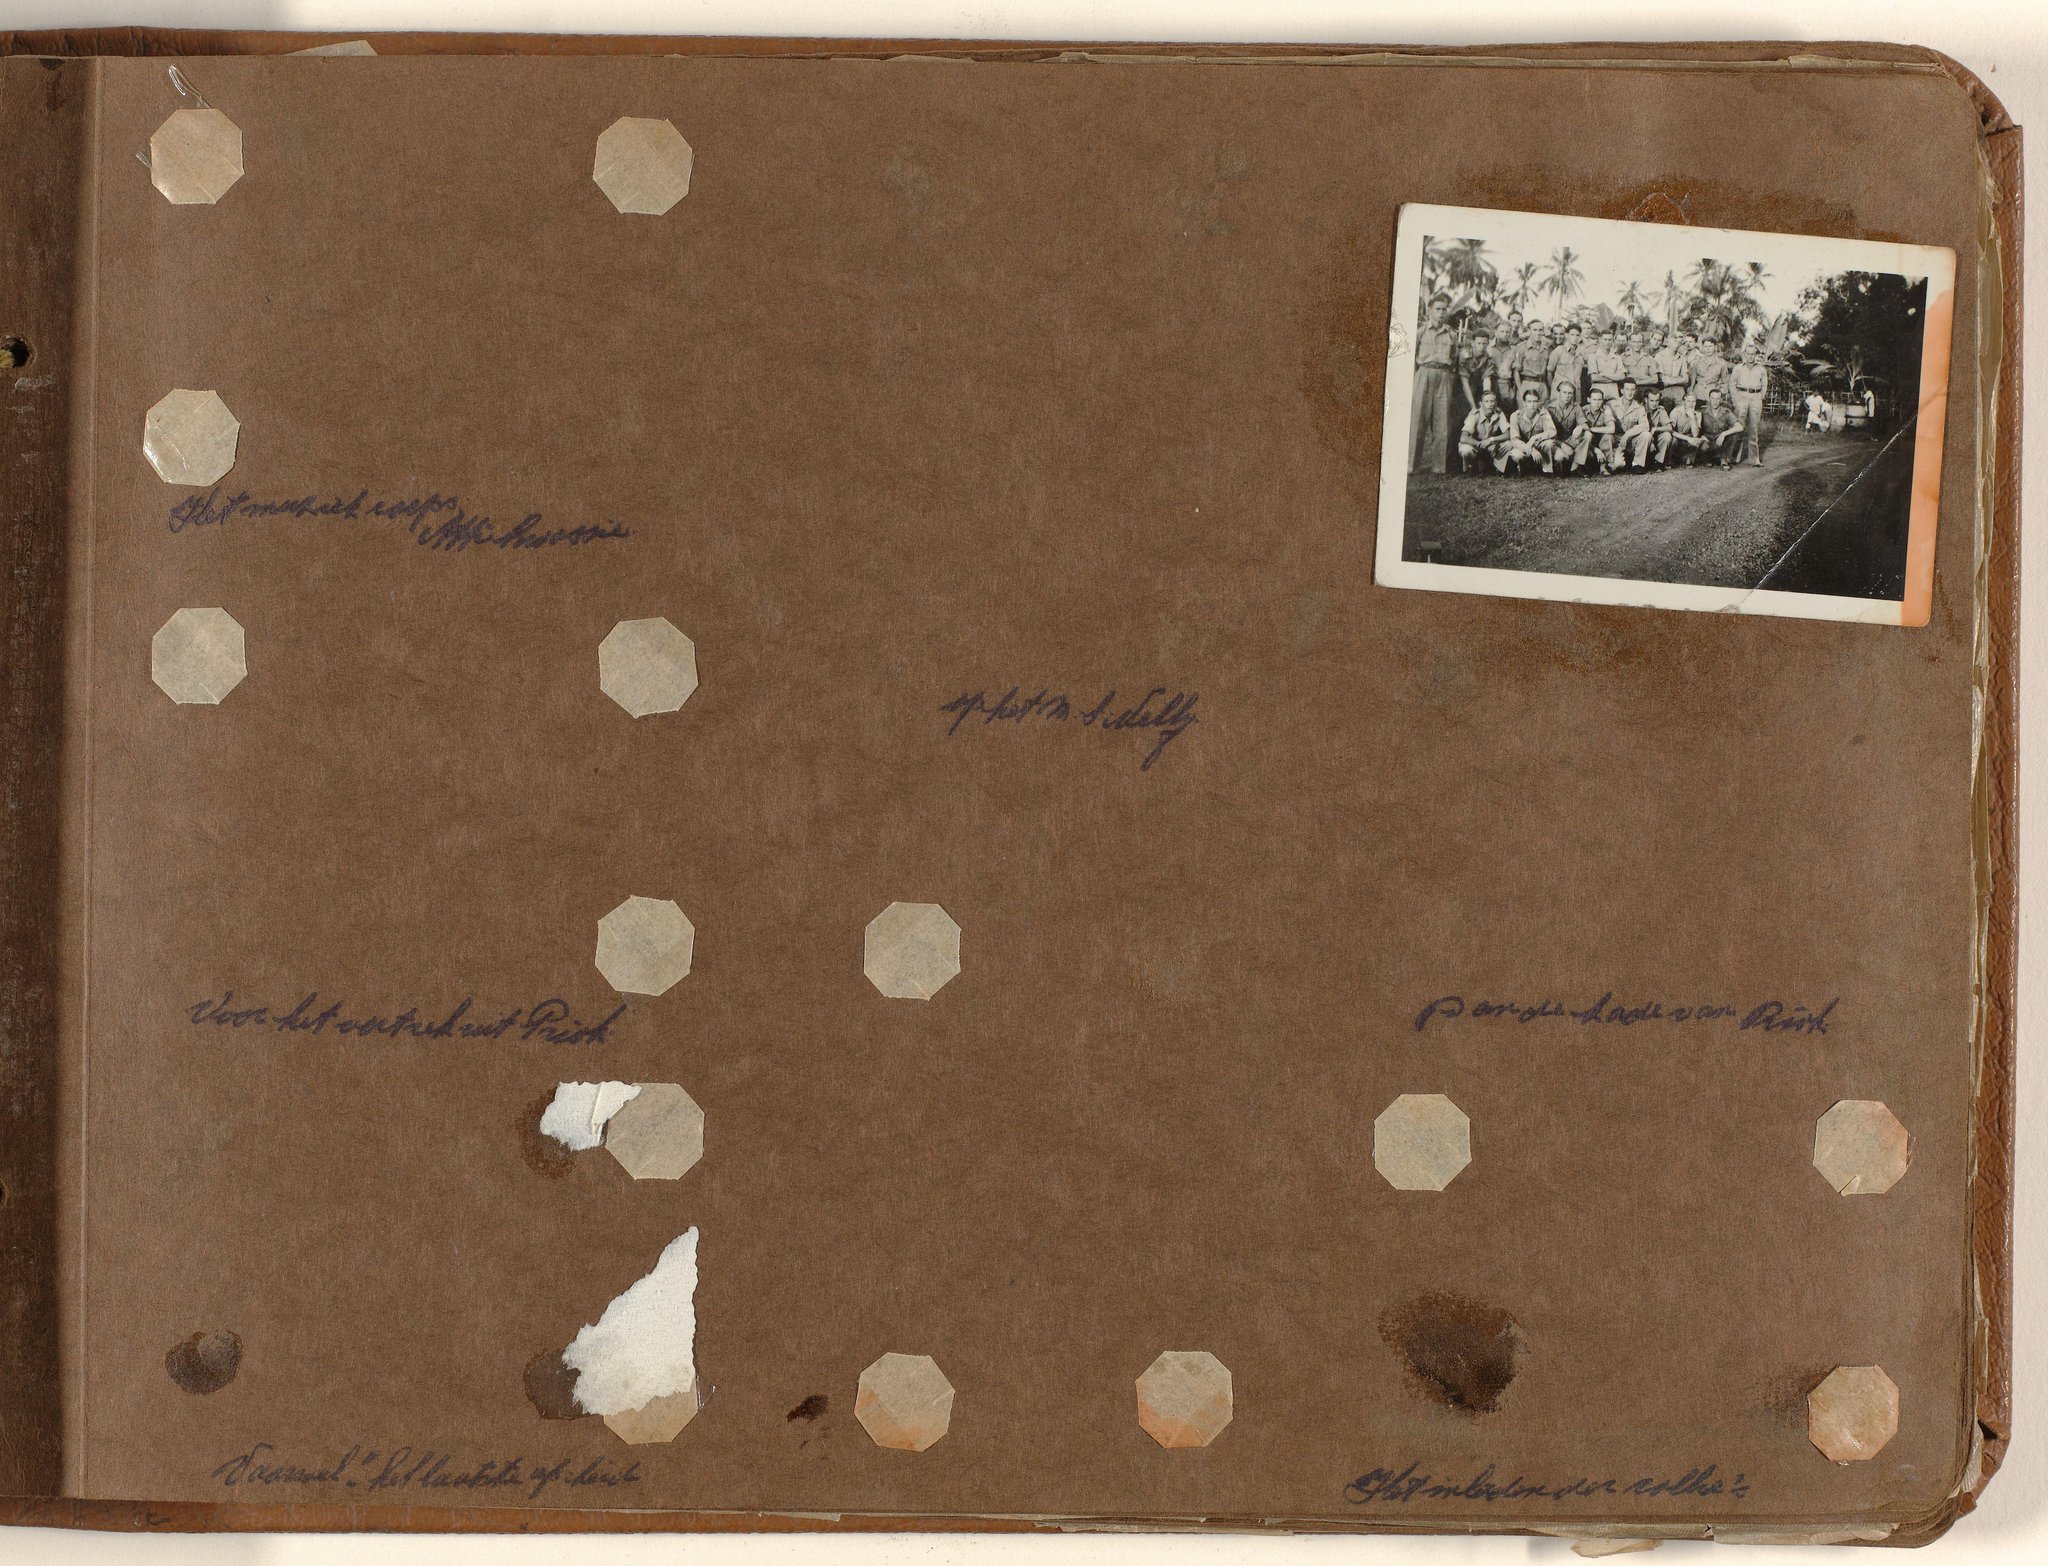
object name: photograph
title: Aankomst in Indië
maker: Anonymous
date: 1901-1948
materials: photographic support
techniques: photography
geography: semarang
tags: the company, the unit, the troop ~ military service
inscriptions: annotation: ‘Muziekcorps, Panama Nelly, Voor het vertrek uit Priok, Aan de kade van Priok, Vaarwel het laatste afscheid, Inladen.’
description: Albumblad met één foto. De andere vijf foto's ontbreken, maar bevatten wel opschriften. De enige aanwezige foto, is een groepsfoto van soldaten in tropenuniform, waarschijnlijk vlak na aankomst op Semarang op 16 januari 1948.